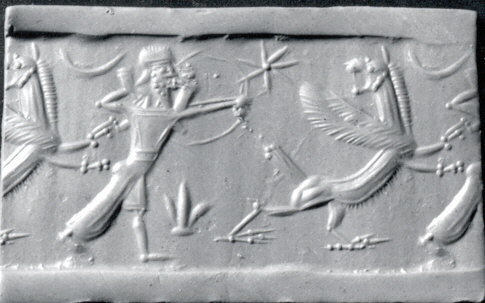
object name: cylinder seal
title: Cylinder seal with mythological contest scene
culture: babylonian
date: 834-701 BCE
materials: stone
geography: mesopotamia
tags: bow and arrow,men,mythical creatures